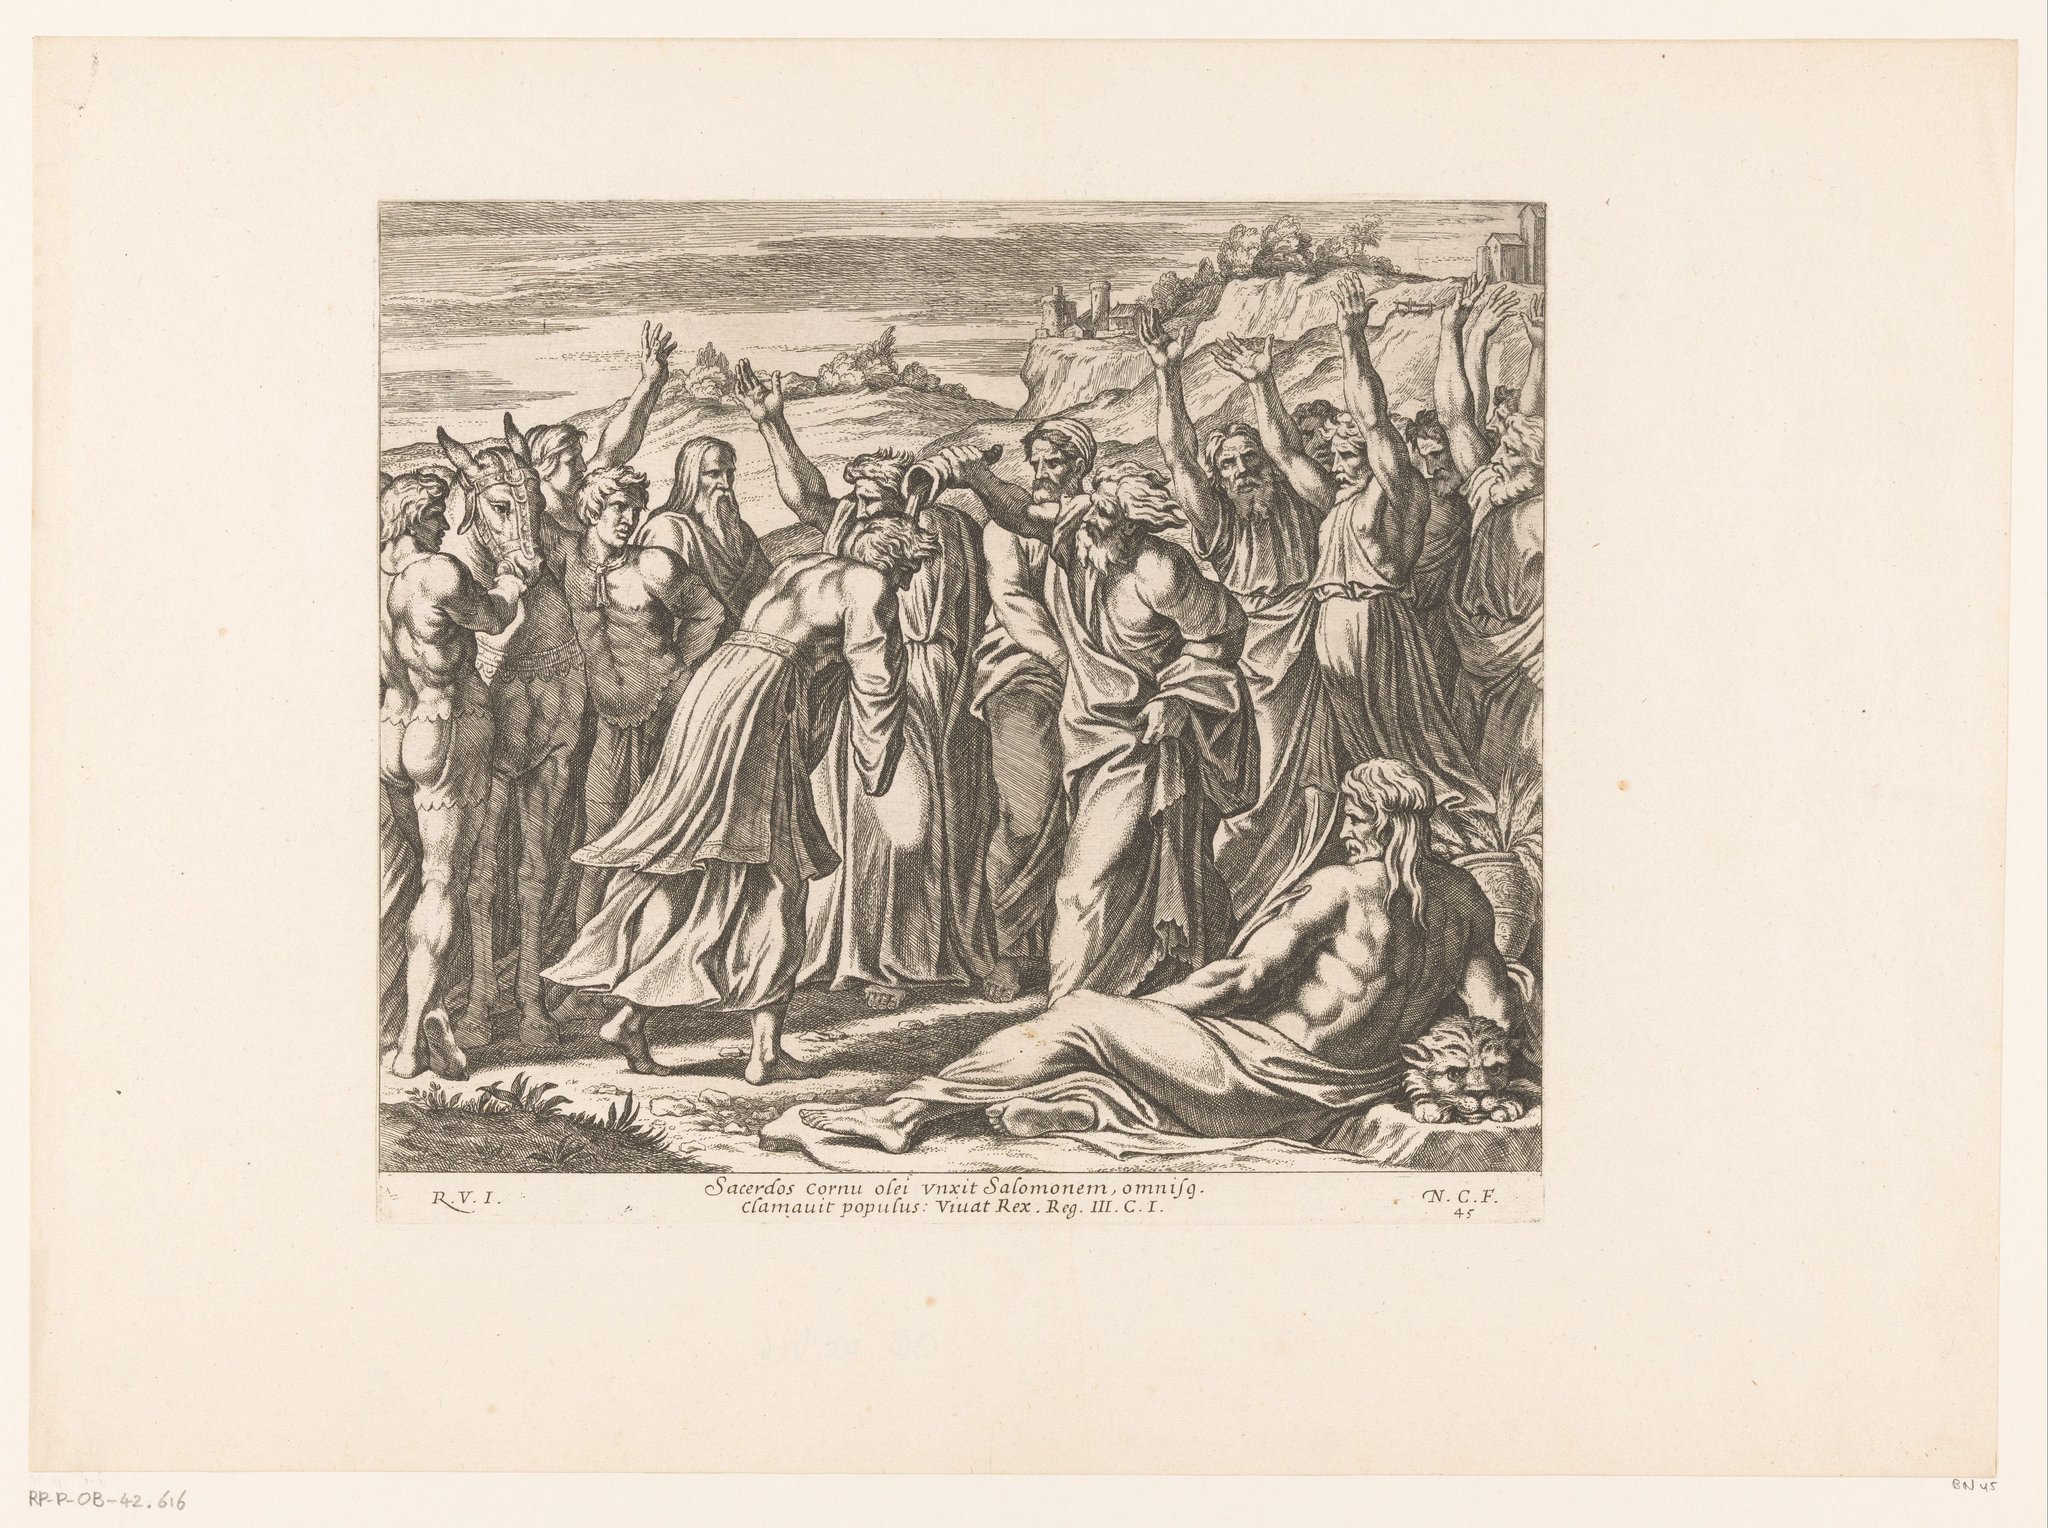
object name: print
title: Rafaël Bijbel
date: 1649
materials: paper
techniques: etching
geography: vatican city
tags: solomon anointed king by zadok; all the people rejoice and blow their trumpets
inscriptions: collector's mark: Lugt 2228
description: Prent uit de Sacrae Historiae Acta a Raphael Urbin in Vaticanis xystis ad picturae miraculum expressa, ook bekend als de Rafaël Bijbel. De serie bestaat uit 54 platen, waarvan twee titelprenten, de eerste met een opdracht aan Rafaël, de tweede met een opdracht aan Renard. De overige 52 platen betreffen composities naar schilderingen in de Loggia van Rafaël in het Vaticaan. De serie werd in 1649 uitgegeven door Pierre Mariette te Parijs.